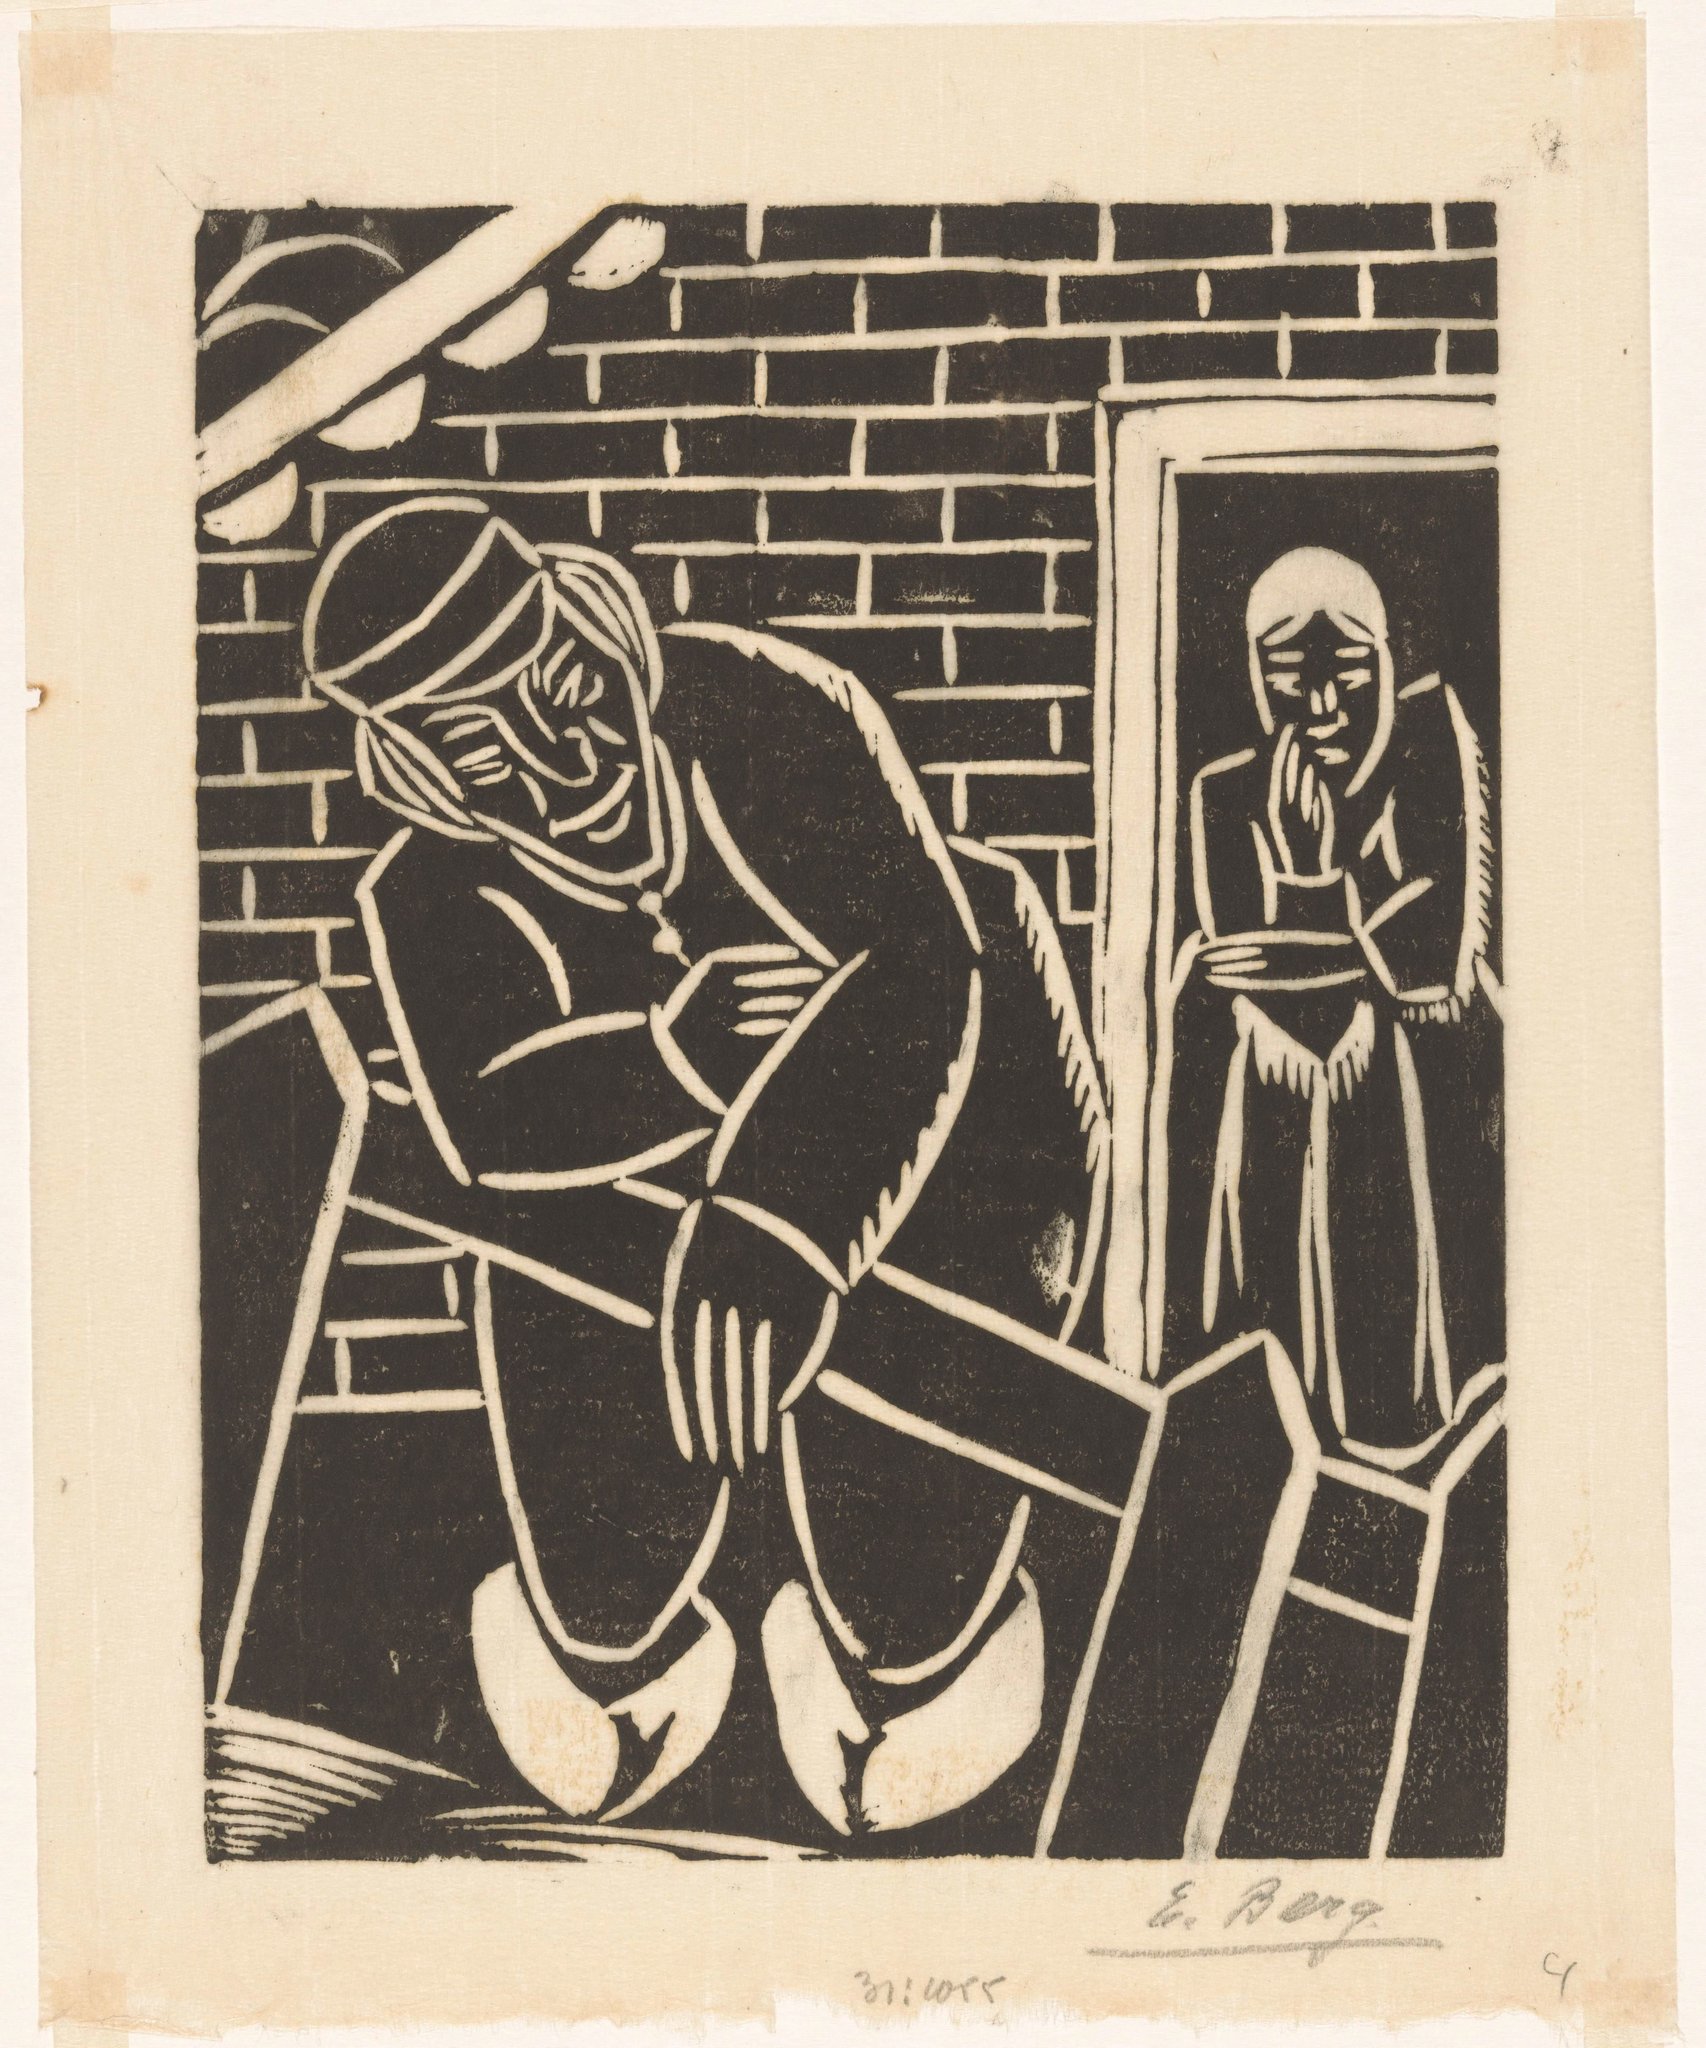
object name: print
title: Boer voor zijn woning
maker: else berg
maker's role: designer, draughtsman, painter, print maker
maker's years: 1877-1942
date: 1912-1931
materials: paper, ink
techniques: woodcut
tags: farmers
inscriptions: number: ‘4’, signature: ‘E. Berg’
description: Boer leunend tegen een hek, met achter hem een boerin in een deuropening.